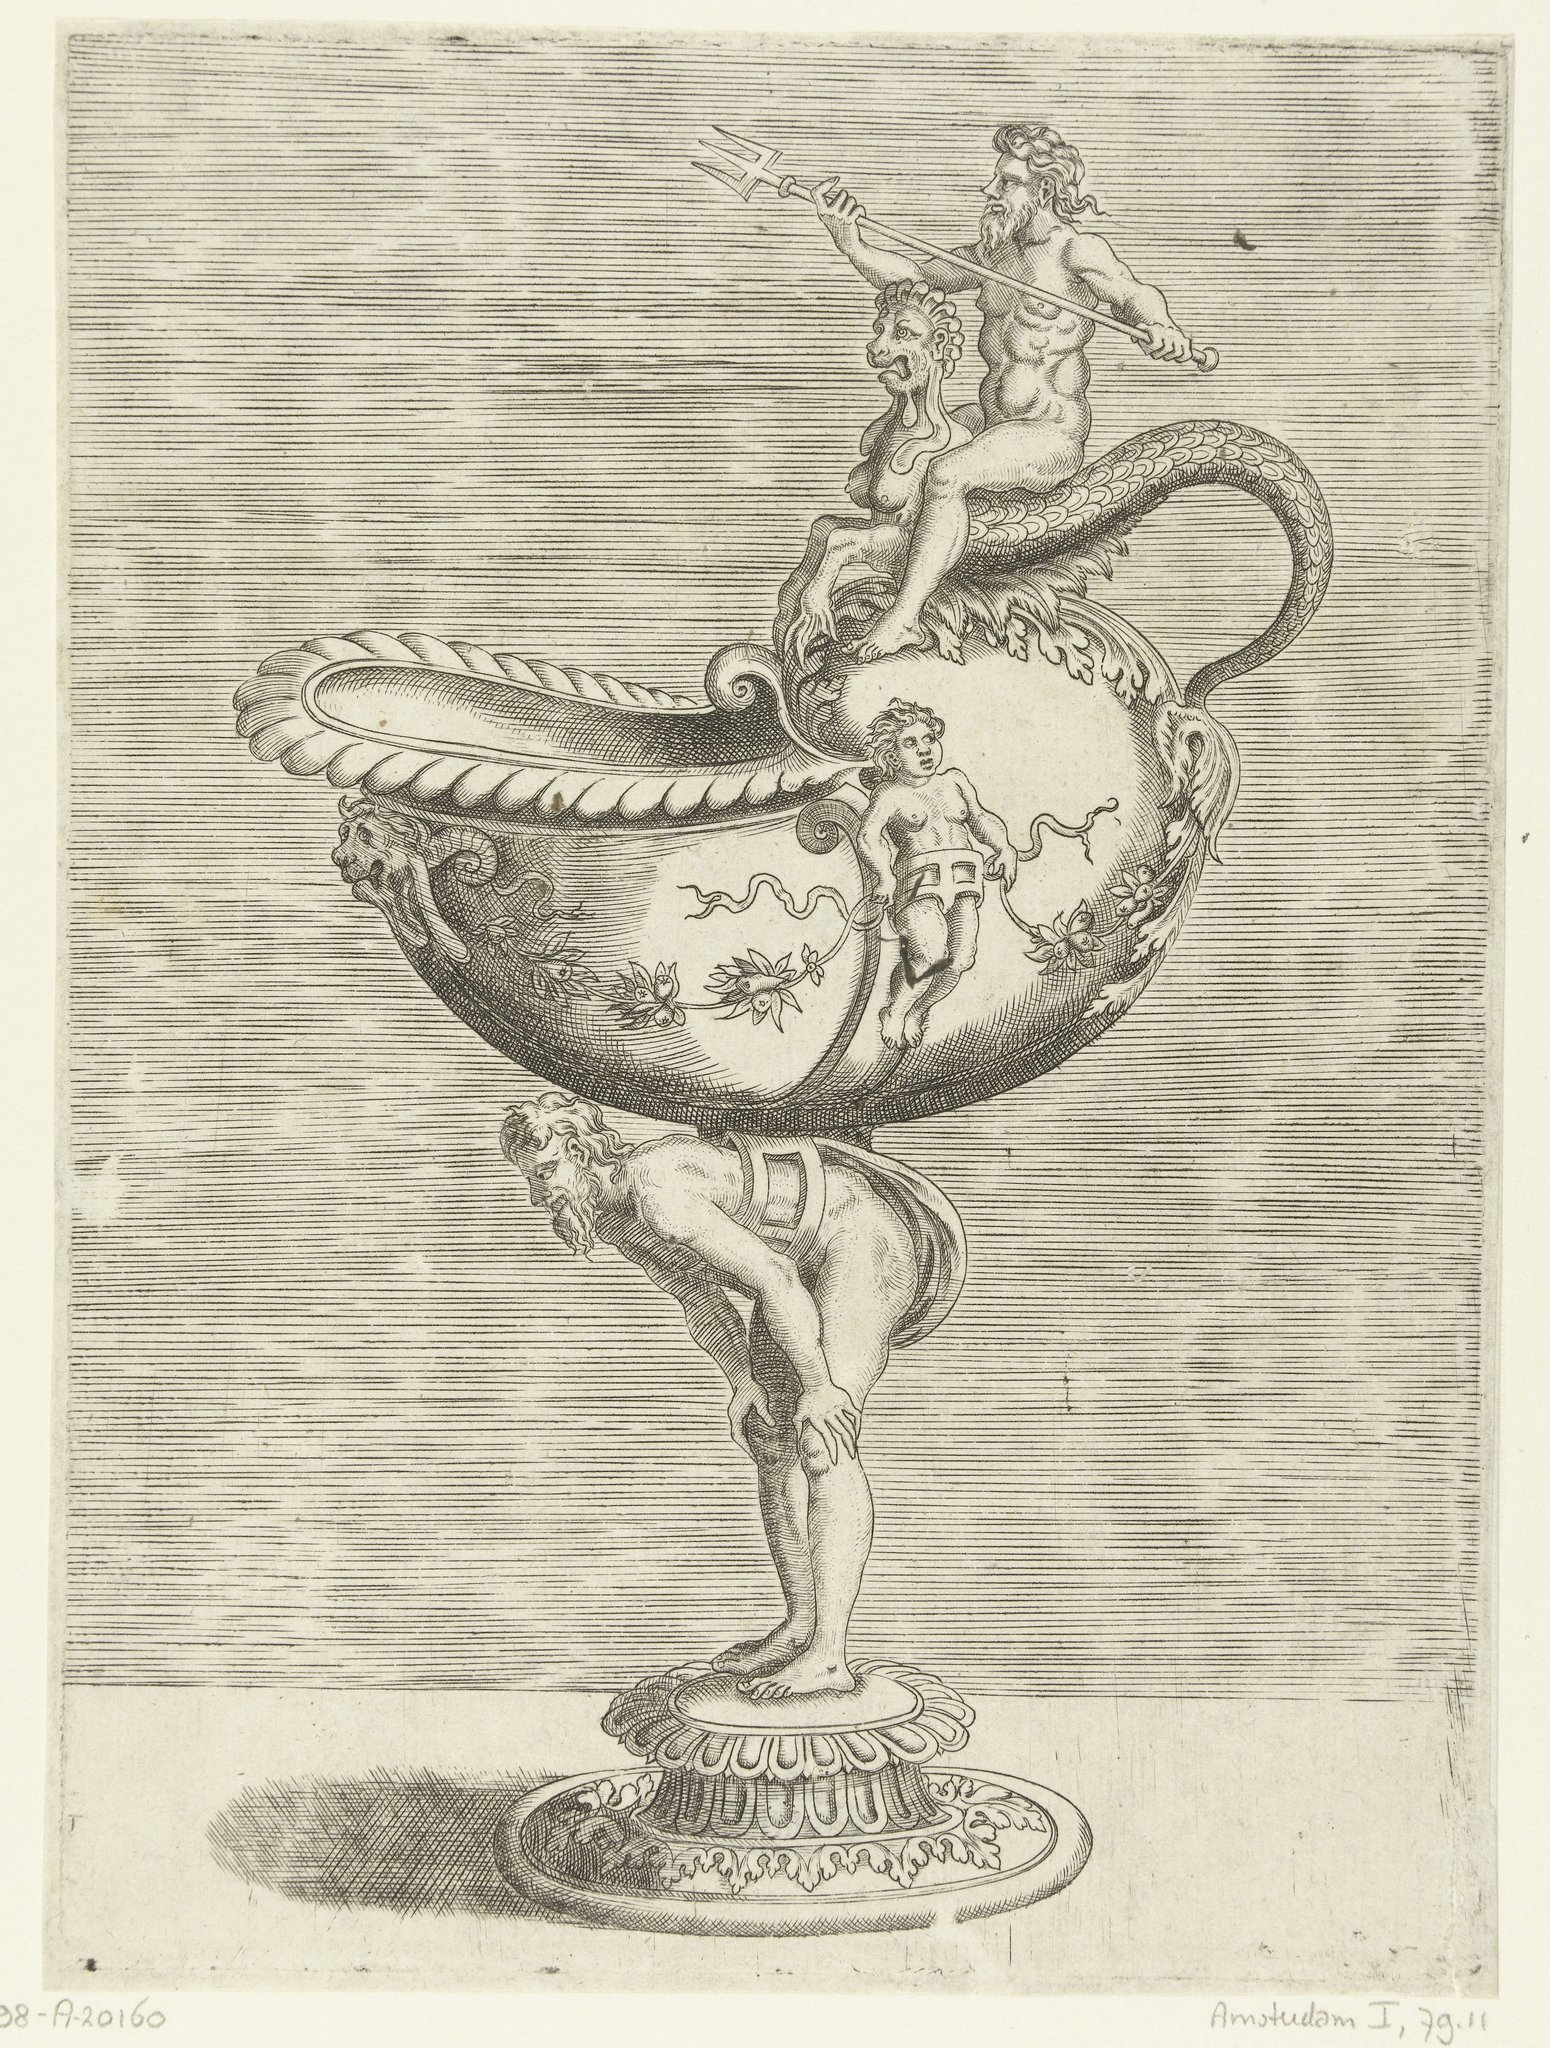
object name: print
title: Nautilusbokaal, rustend op de rug van een man die gebukt staat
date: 1548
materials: paper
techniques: engraving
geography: netherlands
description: Op het oor van de bokaal zit Neptunus met zijn drietand. Afkomstig uit een serie bestaande uit een titelblad en 20 bladen.